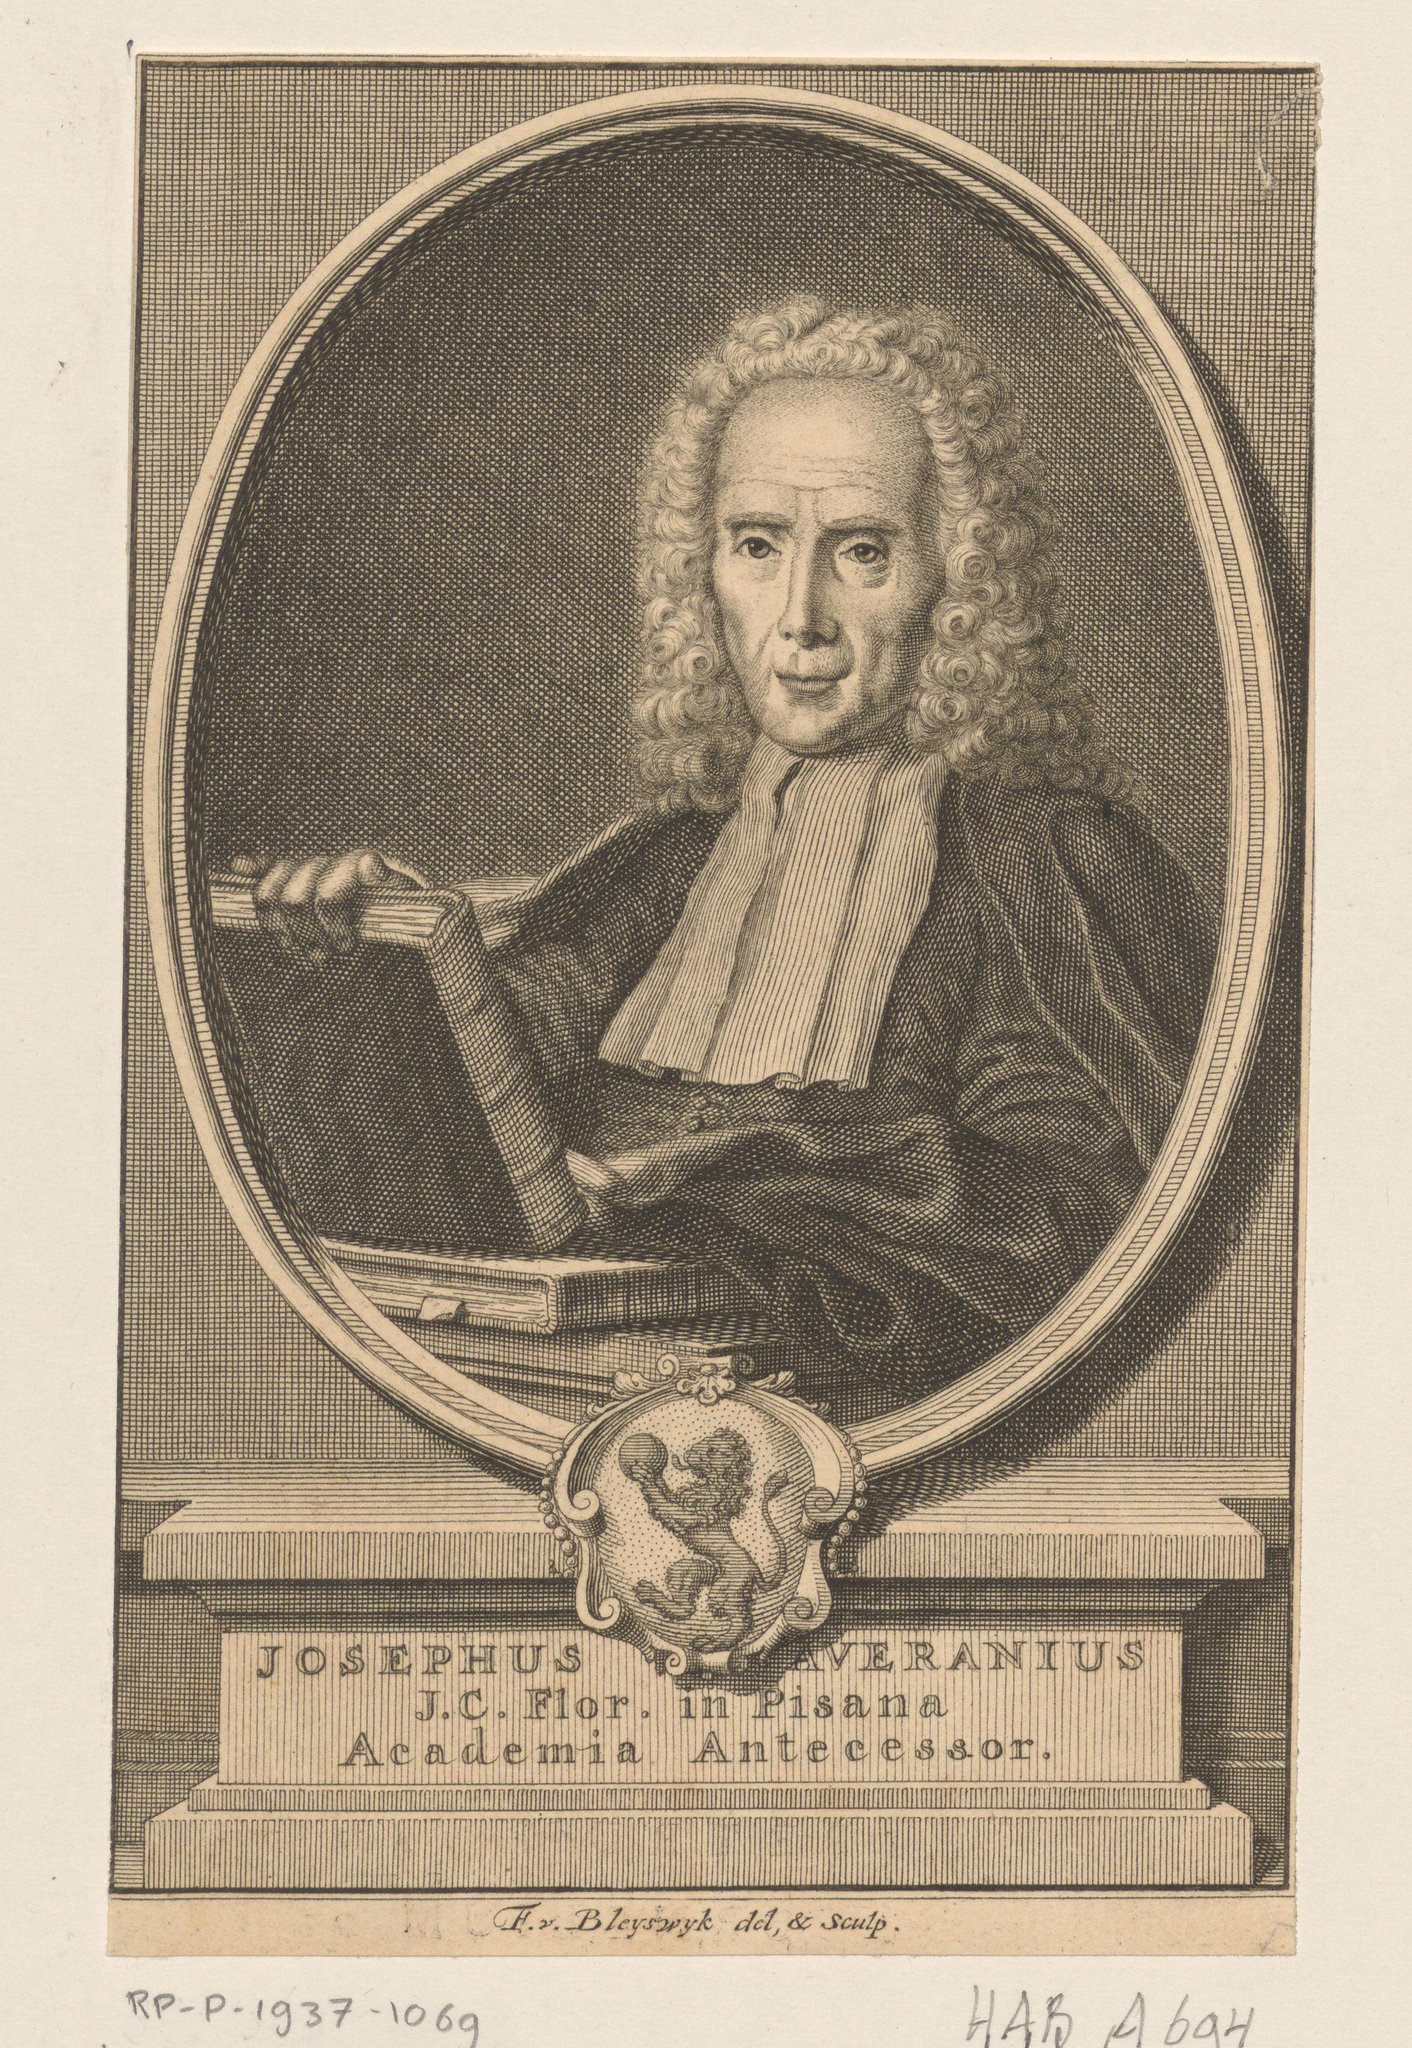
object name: print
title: Portret van Josephus Averanius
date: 1746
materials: paper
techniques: engraving, etching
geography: leiden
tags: historical persons, book, armorial bearing, heraldry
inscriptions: collector's mark: Lugt 2228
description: Prent uit: Averanius, Josephus. Opus postumum, continens interpretationum juris libros tres posterios (...). Leiden: Boudewijn van der Aa, 1746.